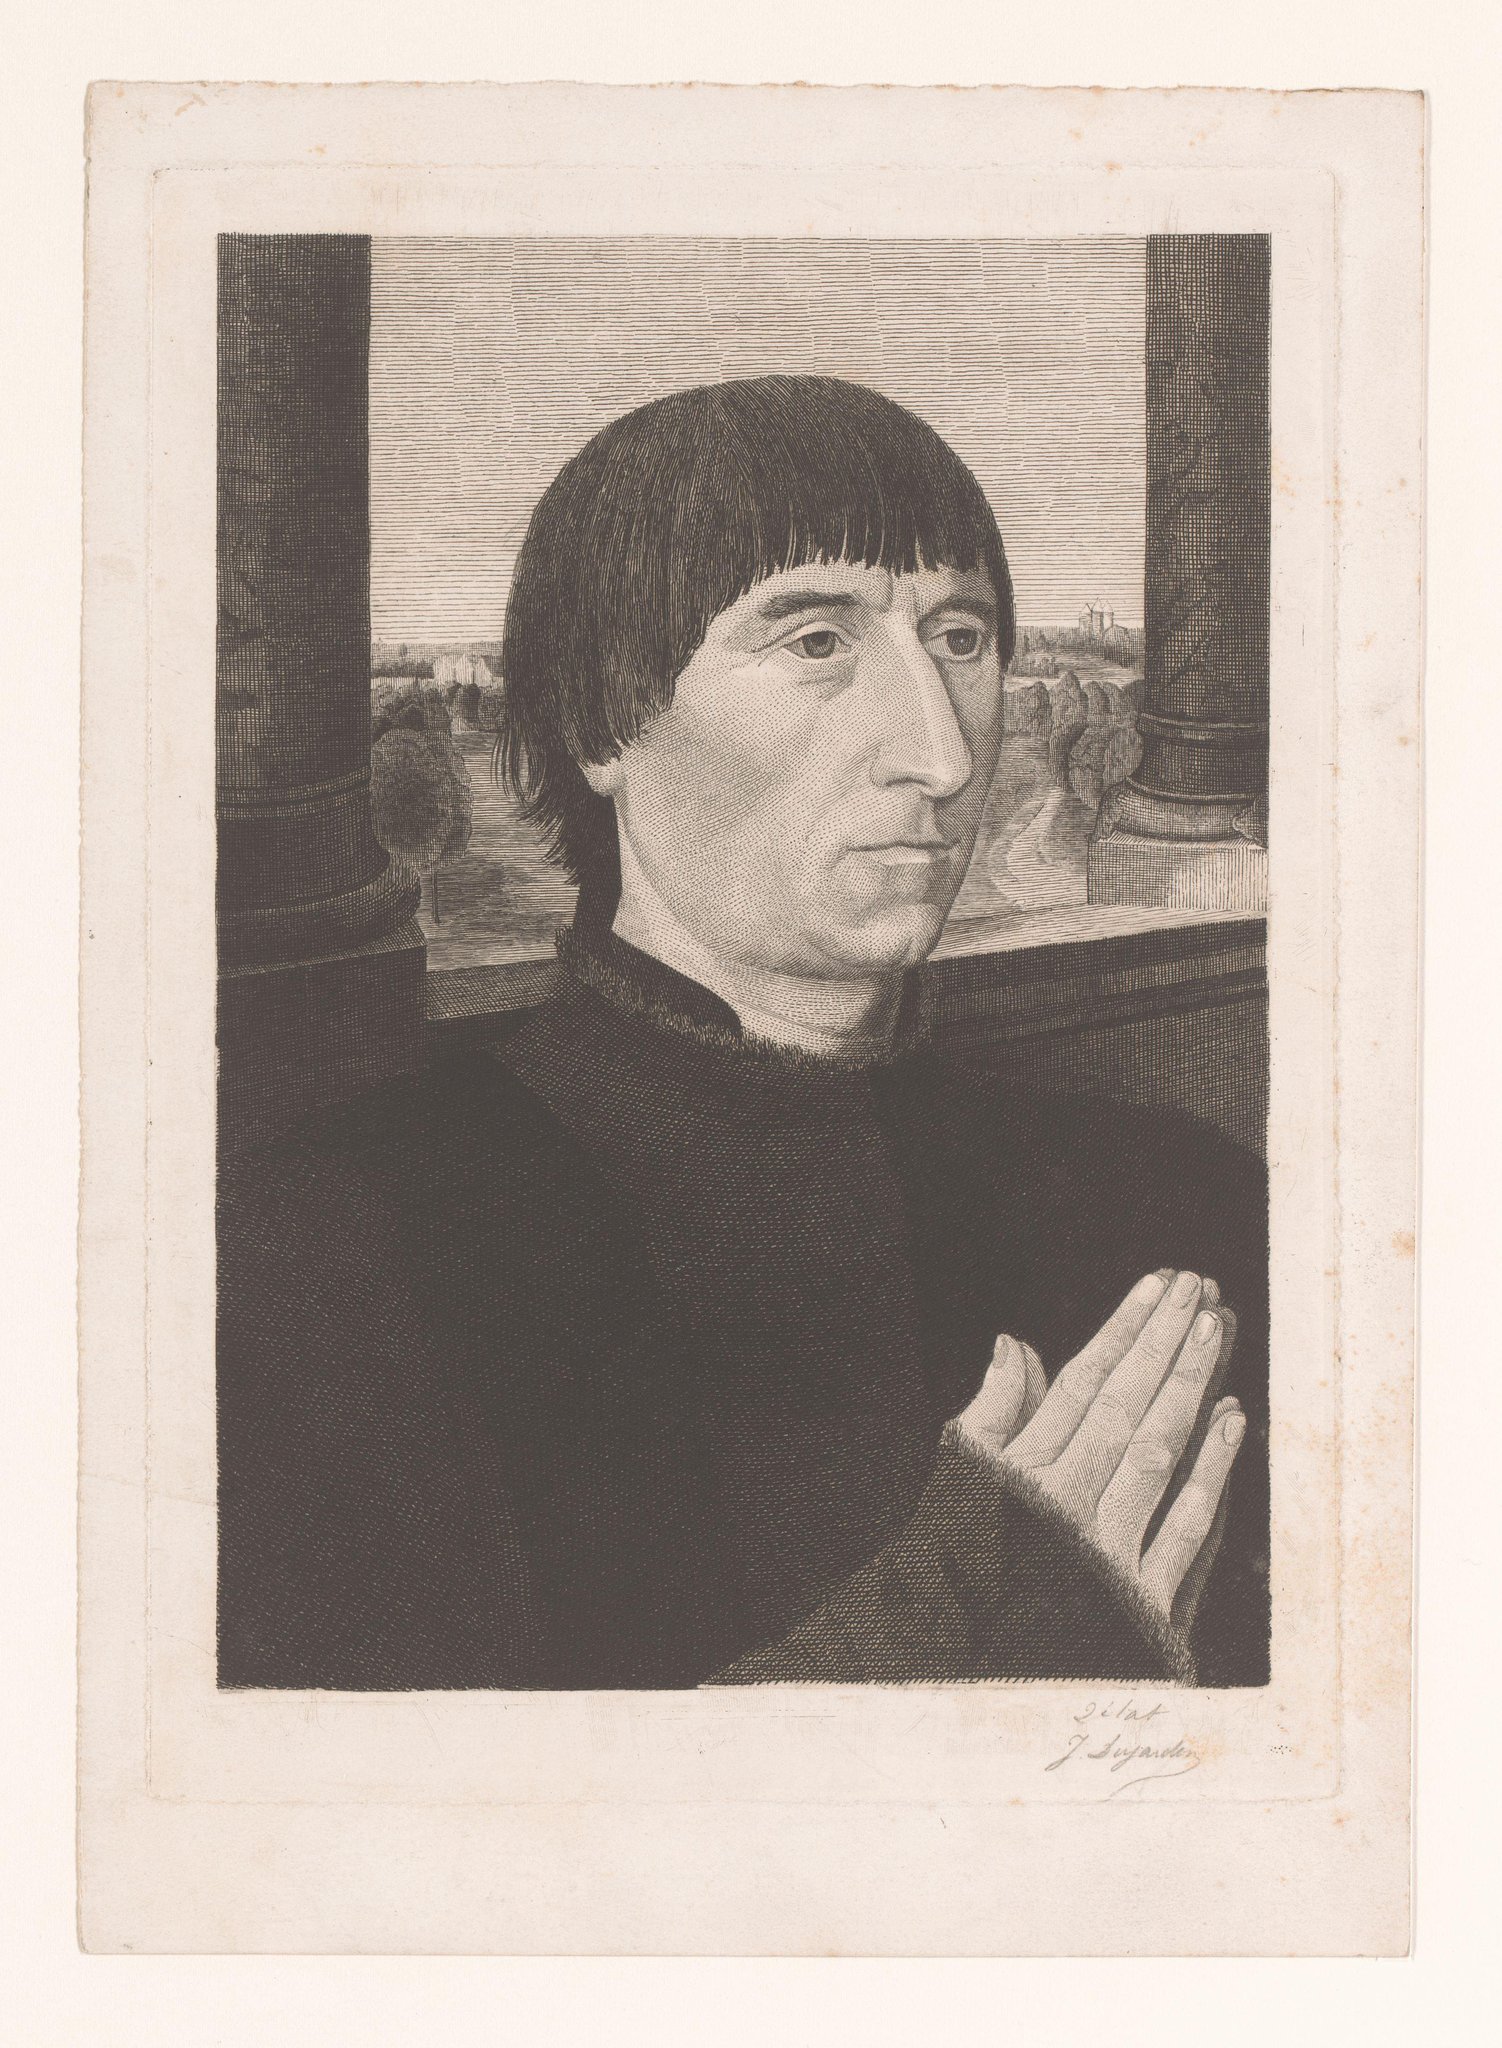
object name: print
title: Donorportret van Willem Moreel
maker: joseph dujardin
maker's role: print maker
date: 1875-1899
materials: paper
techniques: etching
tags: bruges, mayor, adult man, historical persons, hands folded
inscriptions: inscription: ‘2 état’, collector's mark: Lugt 2228